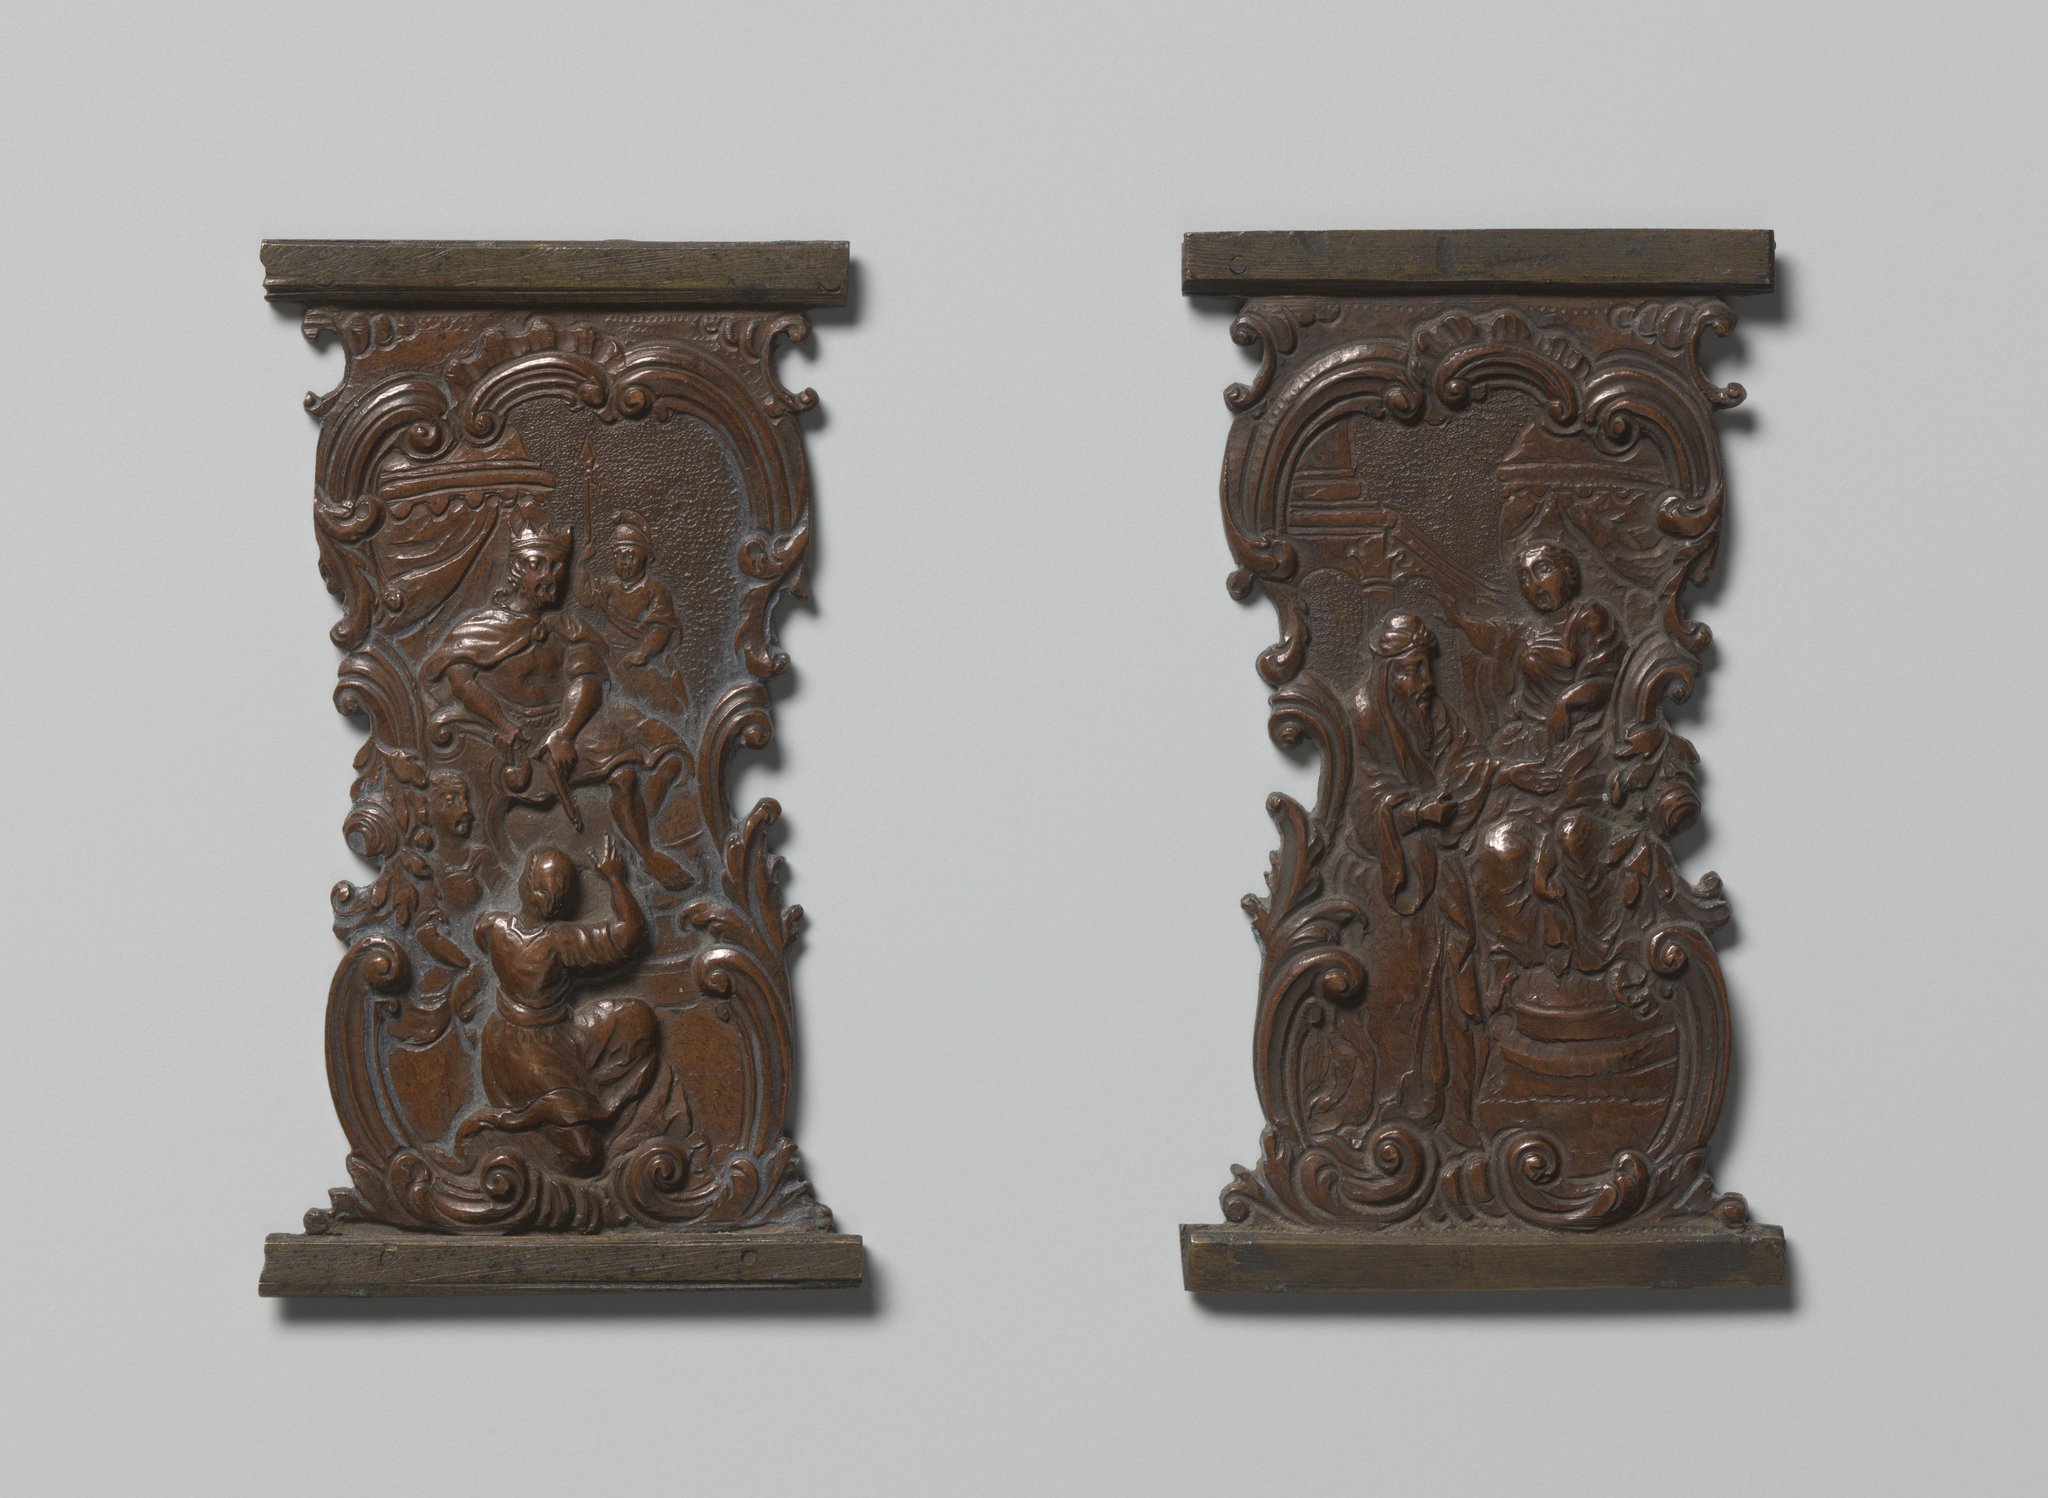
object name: model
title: Modellen voor beugels van een boekslot met Esther voor Ahasveros en Mordechai voor Esther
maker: Anonymous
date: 1750-1775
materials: copper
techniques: riveted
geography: amsterdam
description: In de uit plaat gemaakte modellen voor gietvormen voor beugels zijn twee in rococo-ornament gevatte voorstellingen gedreven van een geknielde vrouw voor een op een troon gezeten koning en van een prieser staande voor een op een verhoging gezeten vrouw. De achterkanten zijn gedeeltelijk met pek opgevuld. Op de smalle zijden zijn rechte lijstjes geklonken. De vier klampen ontbreken.